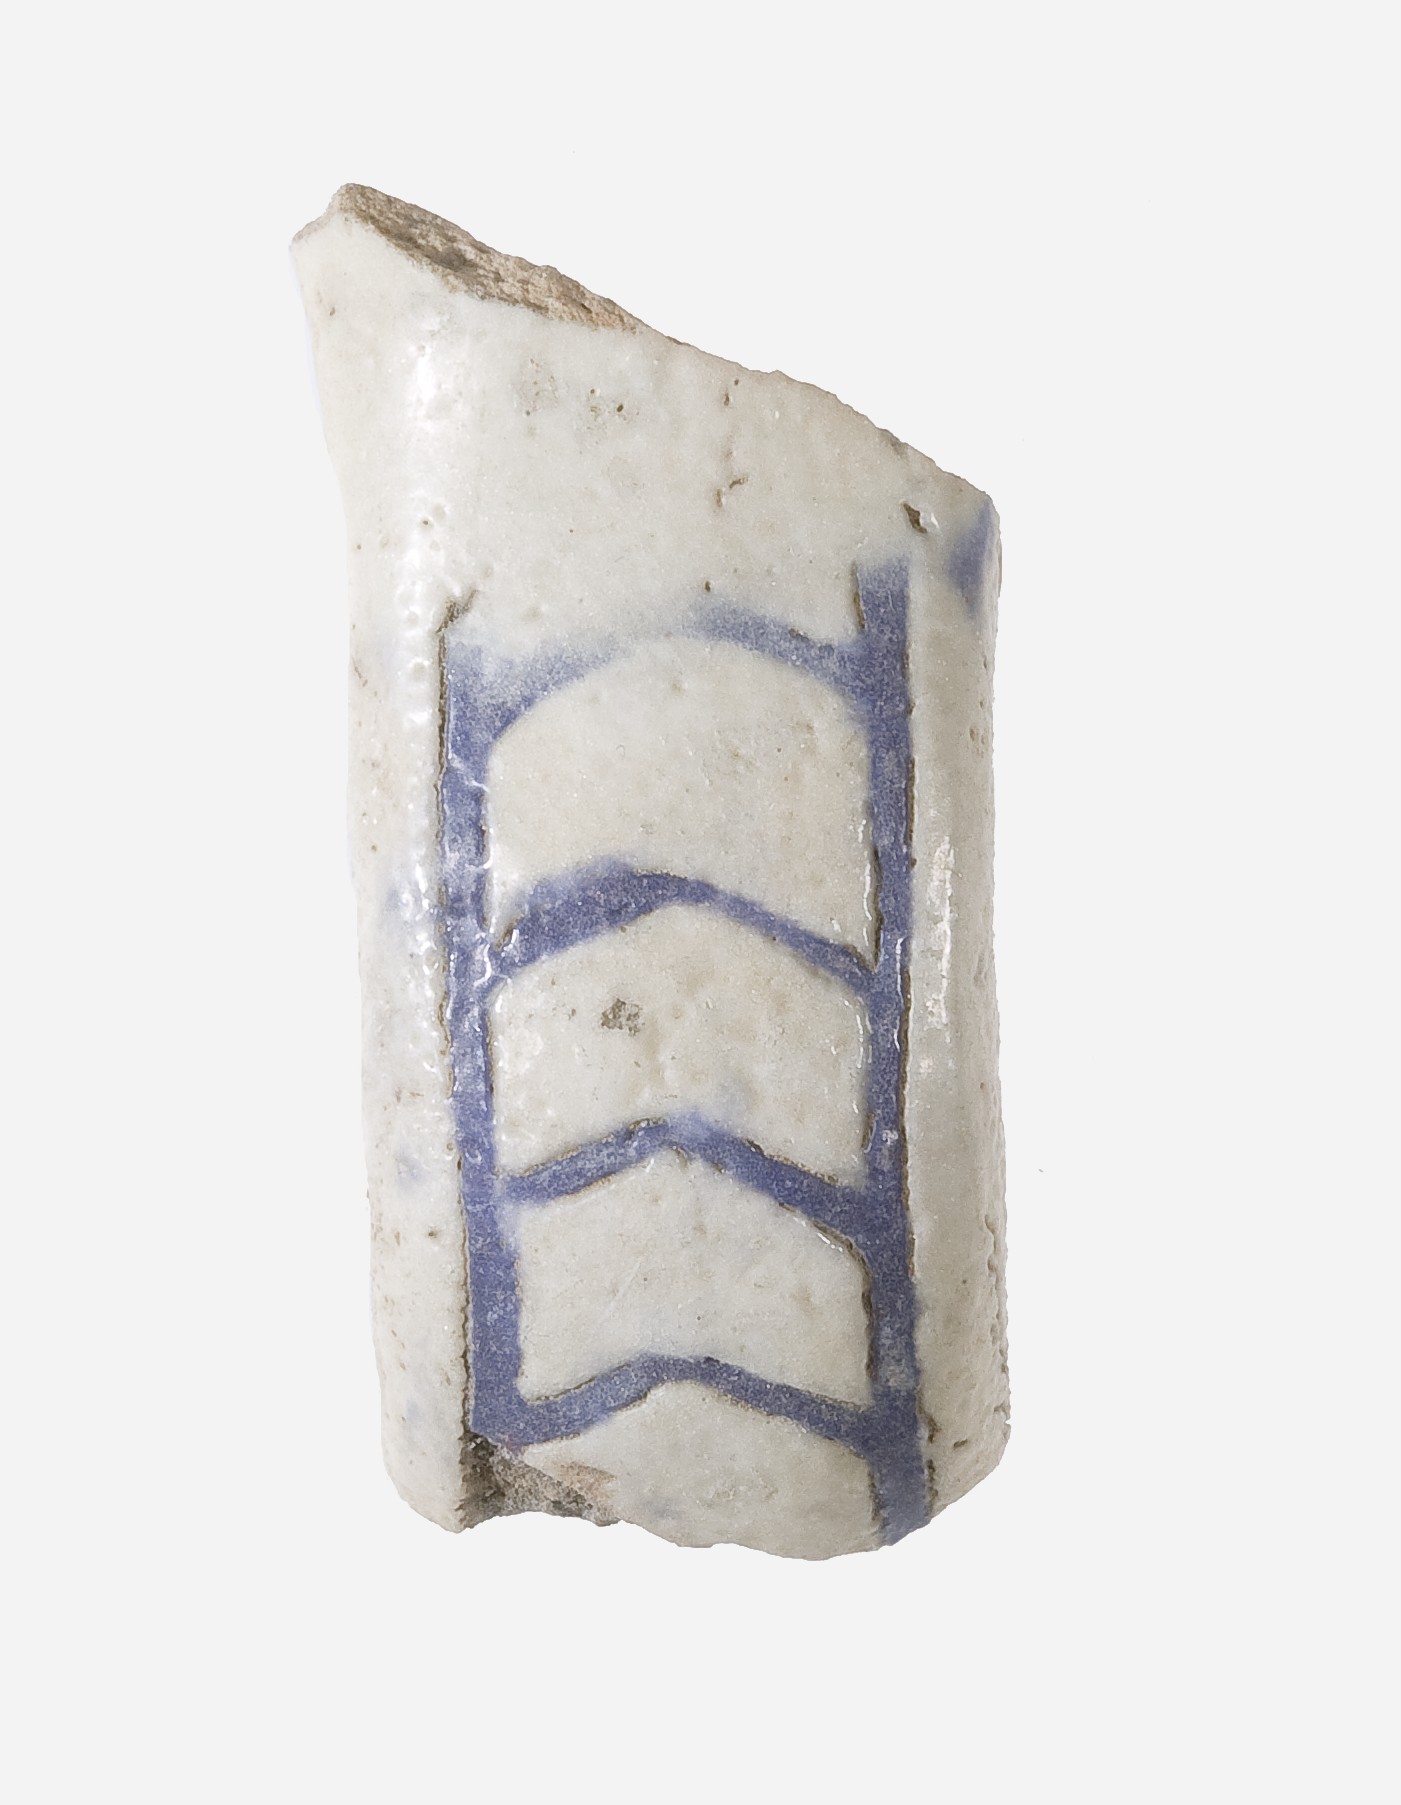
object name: vase fragment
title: Fragment of Vase Handle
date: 1390-1352 BCE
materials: faience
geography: egypt